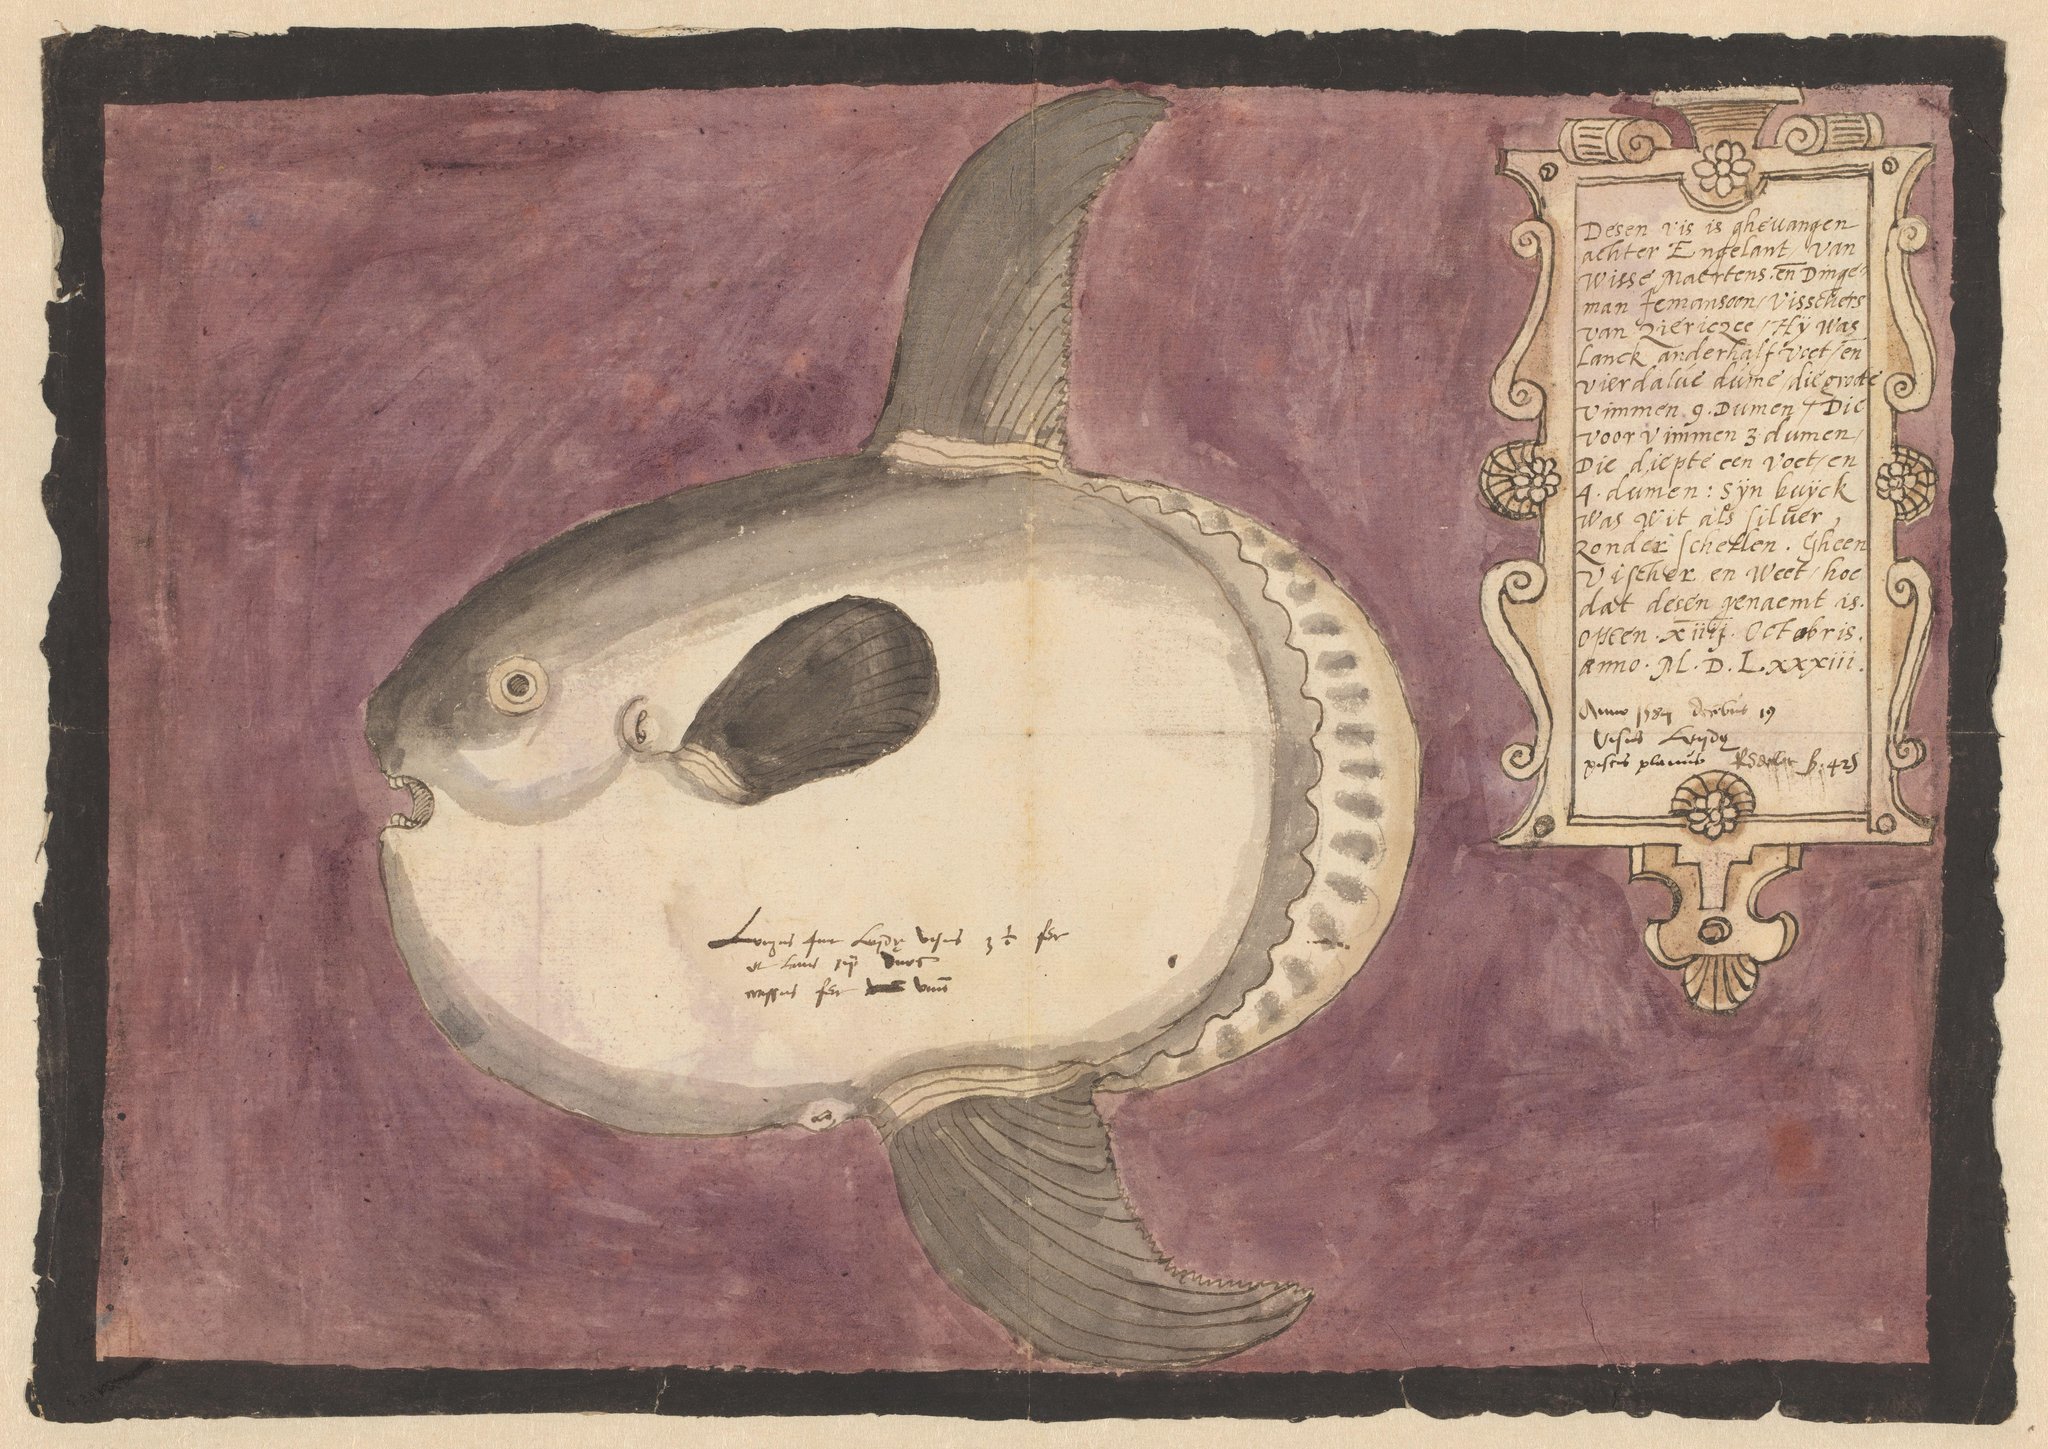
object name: drawing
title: Ocean sunfish (Mola mola)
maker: adriaen coenen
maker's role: draughtsman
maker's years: 1514-1587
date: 1583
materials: graphite, ink, paper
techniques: brush, pen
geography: zeeland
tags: bony fishes: sun-fish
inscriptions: inscription: ‘Anno 1584 Decēbris 19 / Visus Leydae / piscis planus / Rōdelet f. 425’, watermark, inscription: ‘Desen vis is ghevangen / achter Engelant/ van / Wisse Maertens . en Dinge- / man Iemansoon/ visschers / van Ziericzee/ Hij was / lanck anderhalf voet/ en / vierdalve dume /die groote / vimmen 9. Dumen /Die voorvimmen 3 dumen / Die diepte een voet/ en / 4. dumen: sijn buijck / was wit als silver, / zonder schellen. Gheen / vischer en weet/ hoe / dat desen genaemt is. / Op ten xiiij Octobris / Anno MDLxxxiii.’, inscription: ‘Longus fuit Leydae visus 3 ½ fere / et latus […] duos / crassus fere unū’